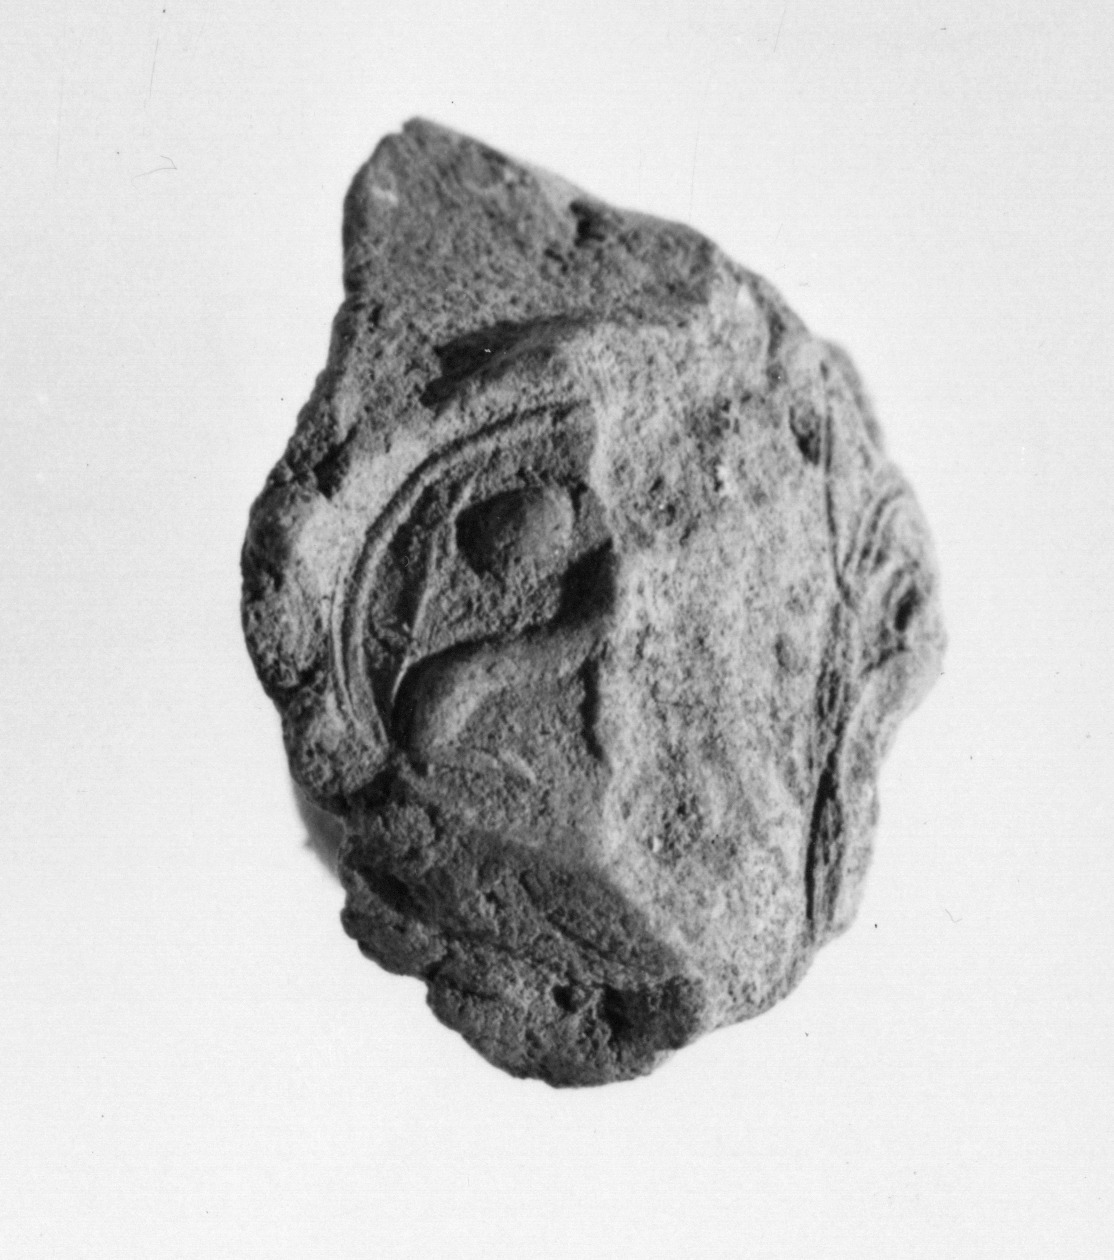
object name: sealing, seth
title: Document Sealing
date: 1390-1352 BCE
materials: mud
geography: egypt